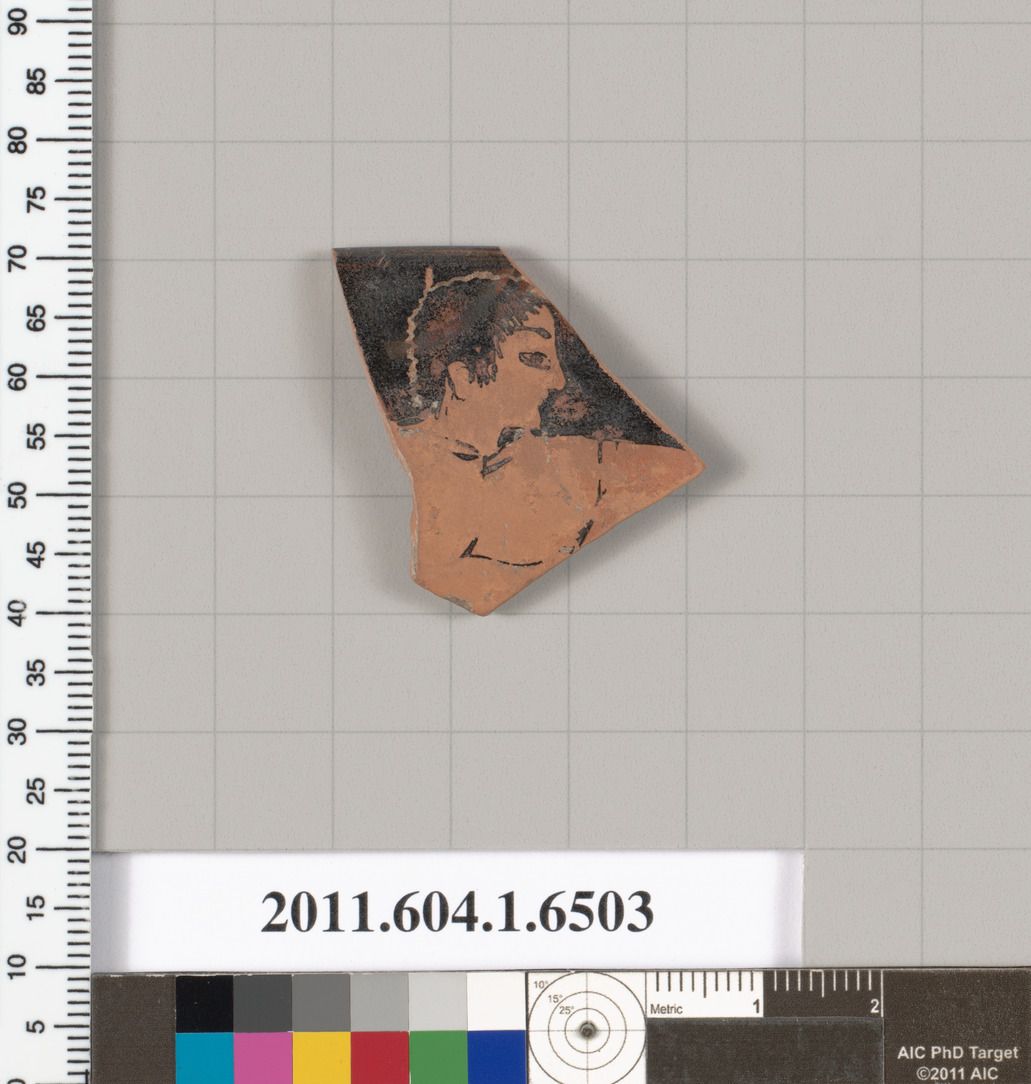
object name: kylix fragment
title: Terracotta rim fragment of a kylix (drinking cup)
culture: greek, attic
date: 490-480 BCE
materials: terracotta